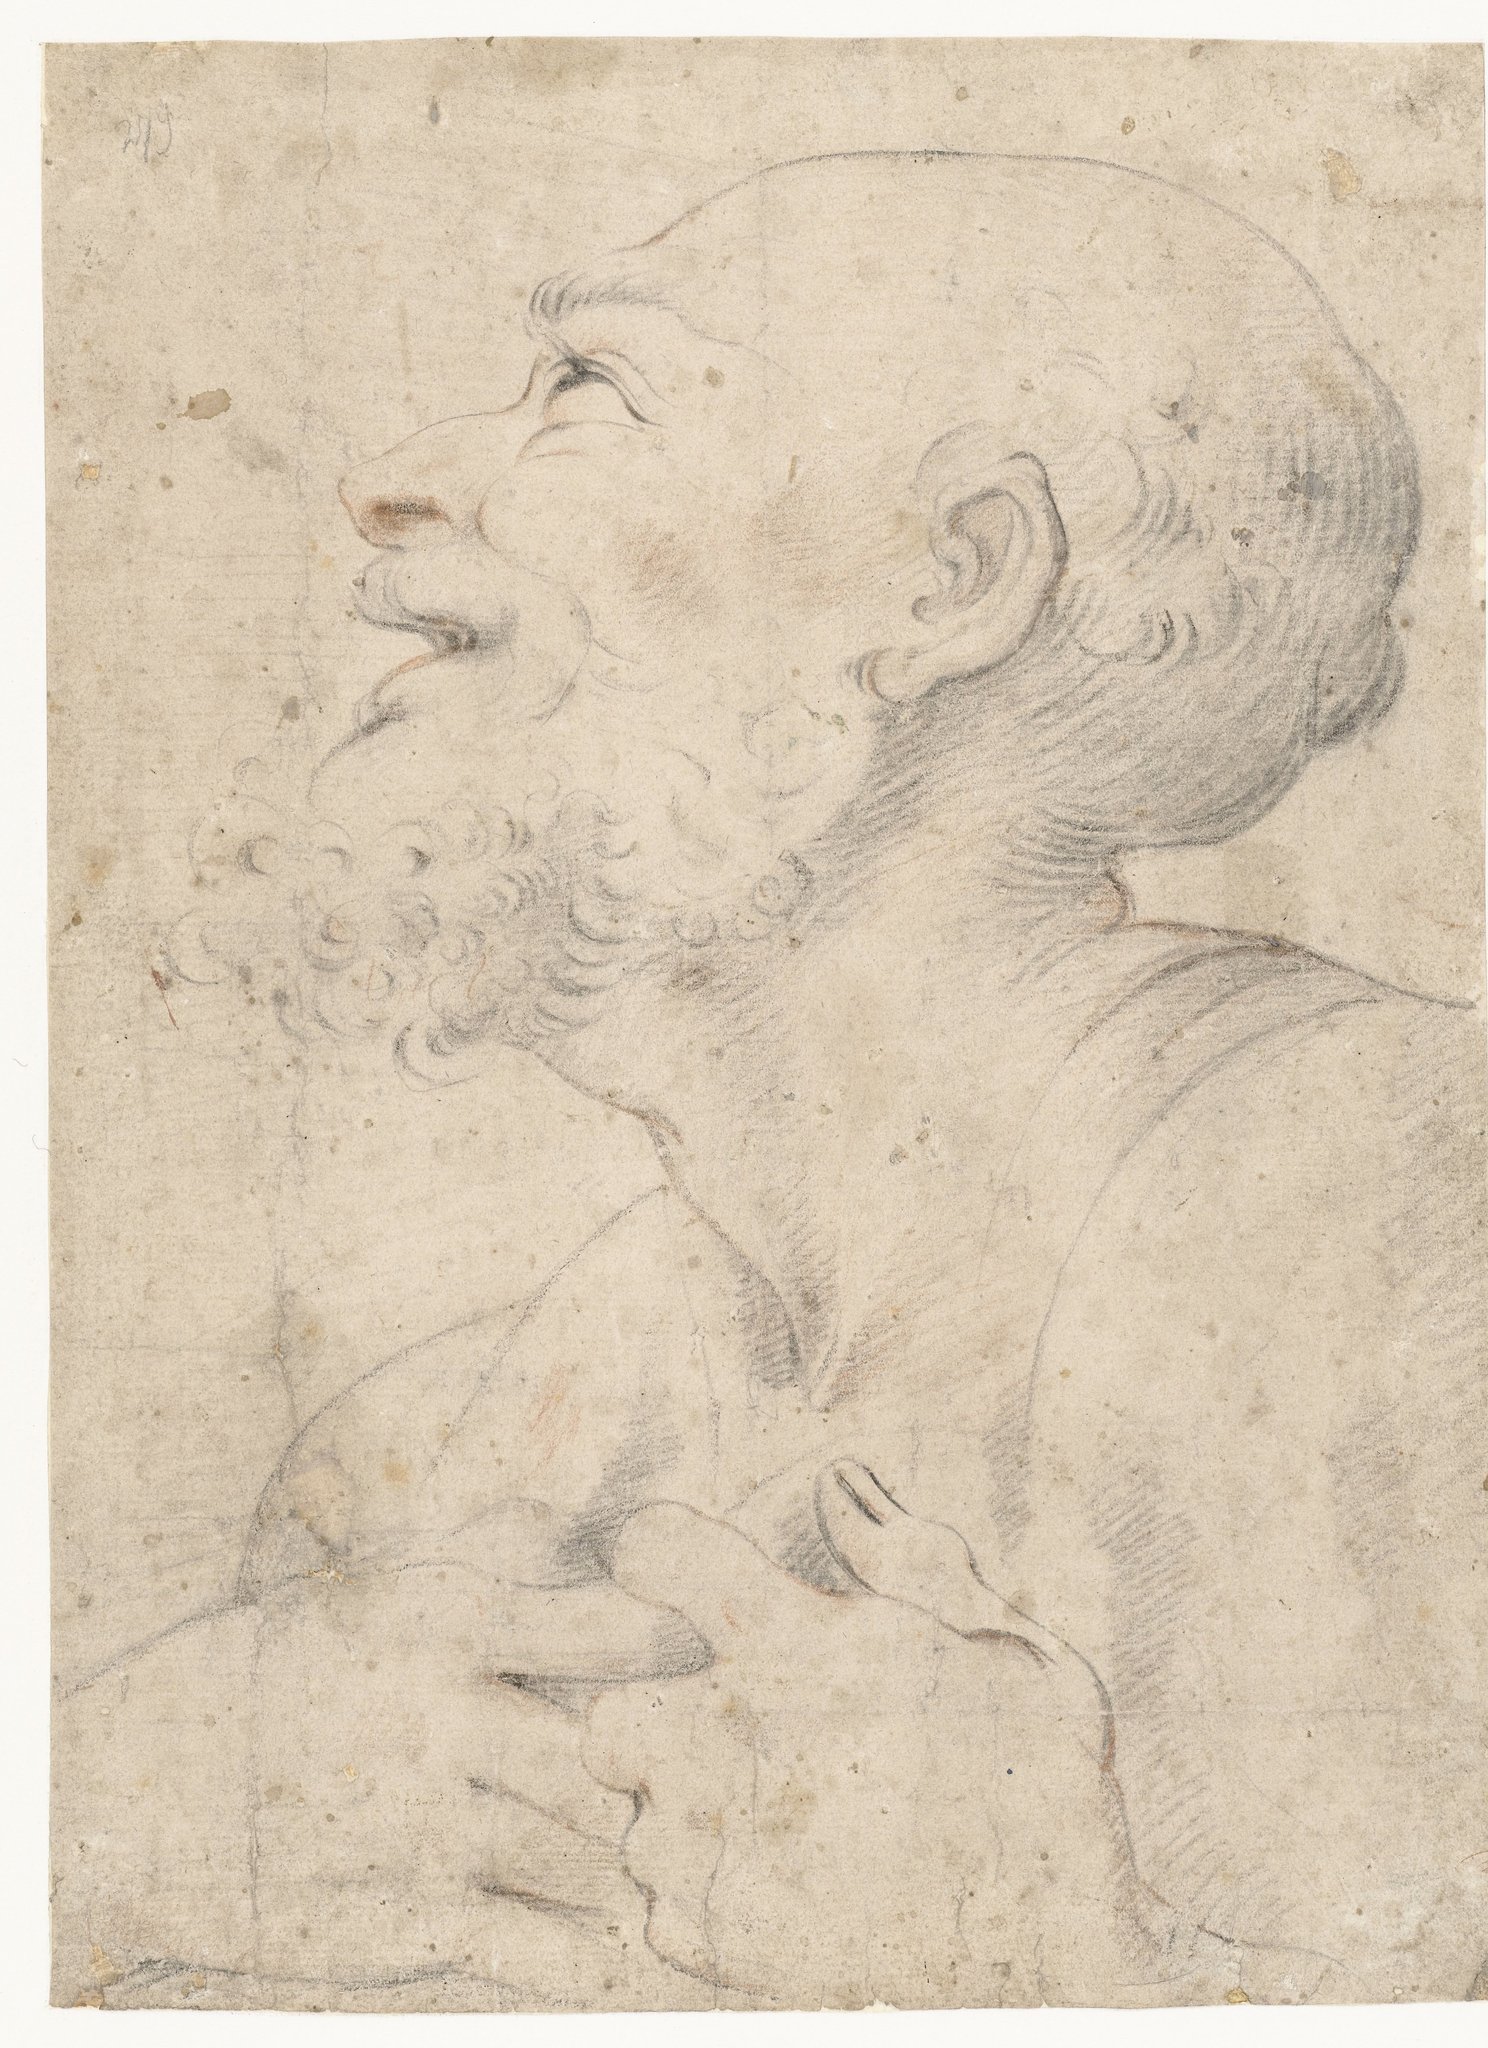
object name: drawing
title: Borstbeeld van een lachende oude man, in profiel naar links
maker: Anonymous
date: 1583-1625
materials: chalk, paper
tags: laughing, old man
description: De originele tekening bevindt zich in een privé collectie te New York.